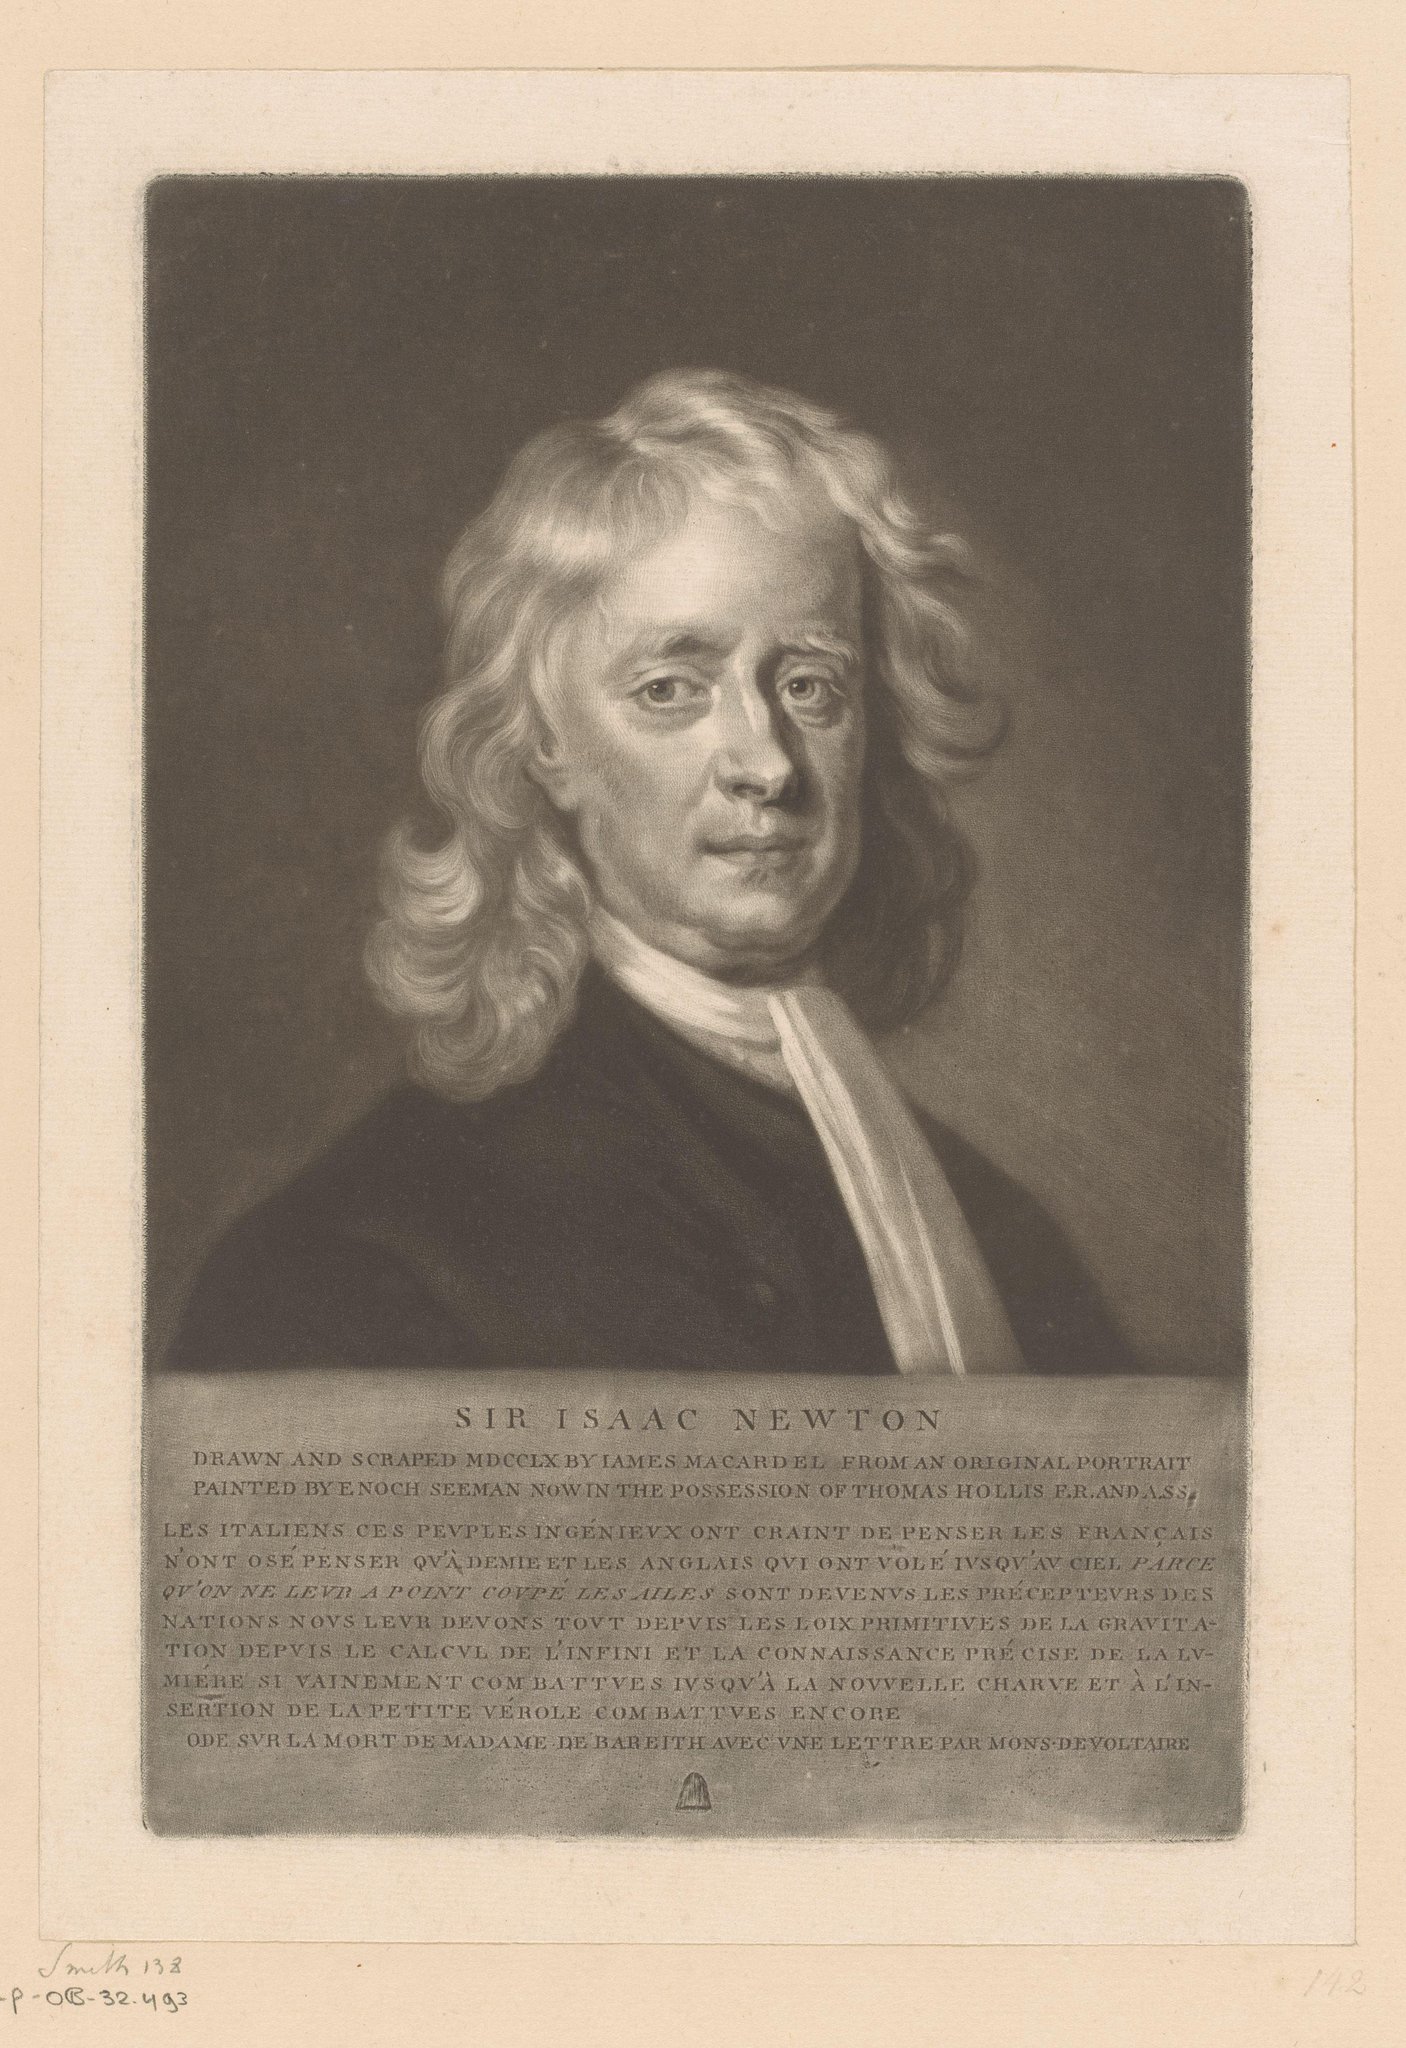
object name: print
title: Sir Isaac Newton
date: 1760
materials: paper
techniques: mezzotint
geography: london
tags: london, physicist, physics (+ portrait of scholar, scientist), historical persons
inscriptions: collector's mark: Lugt 240